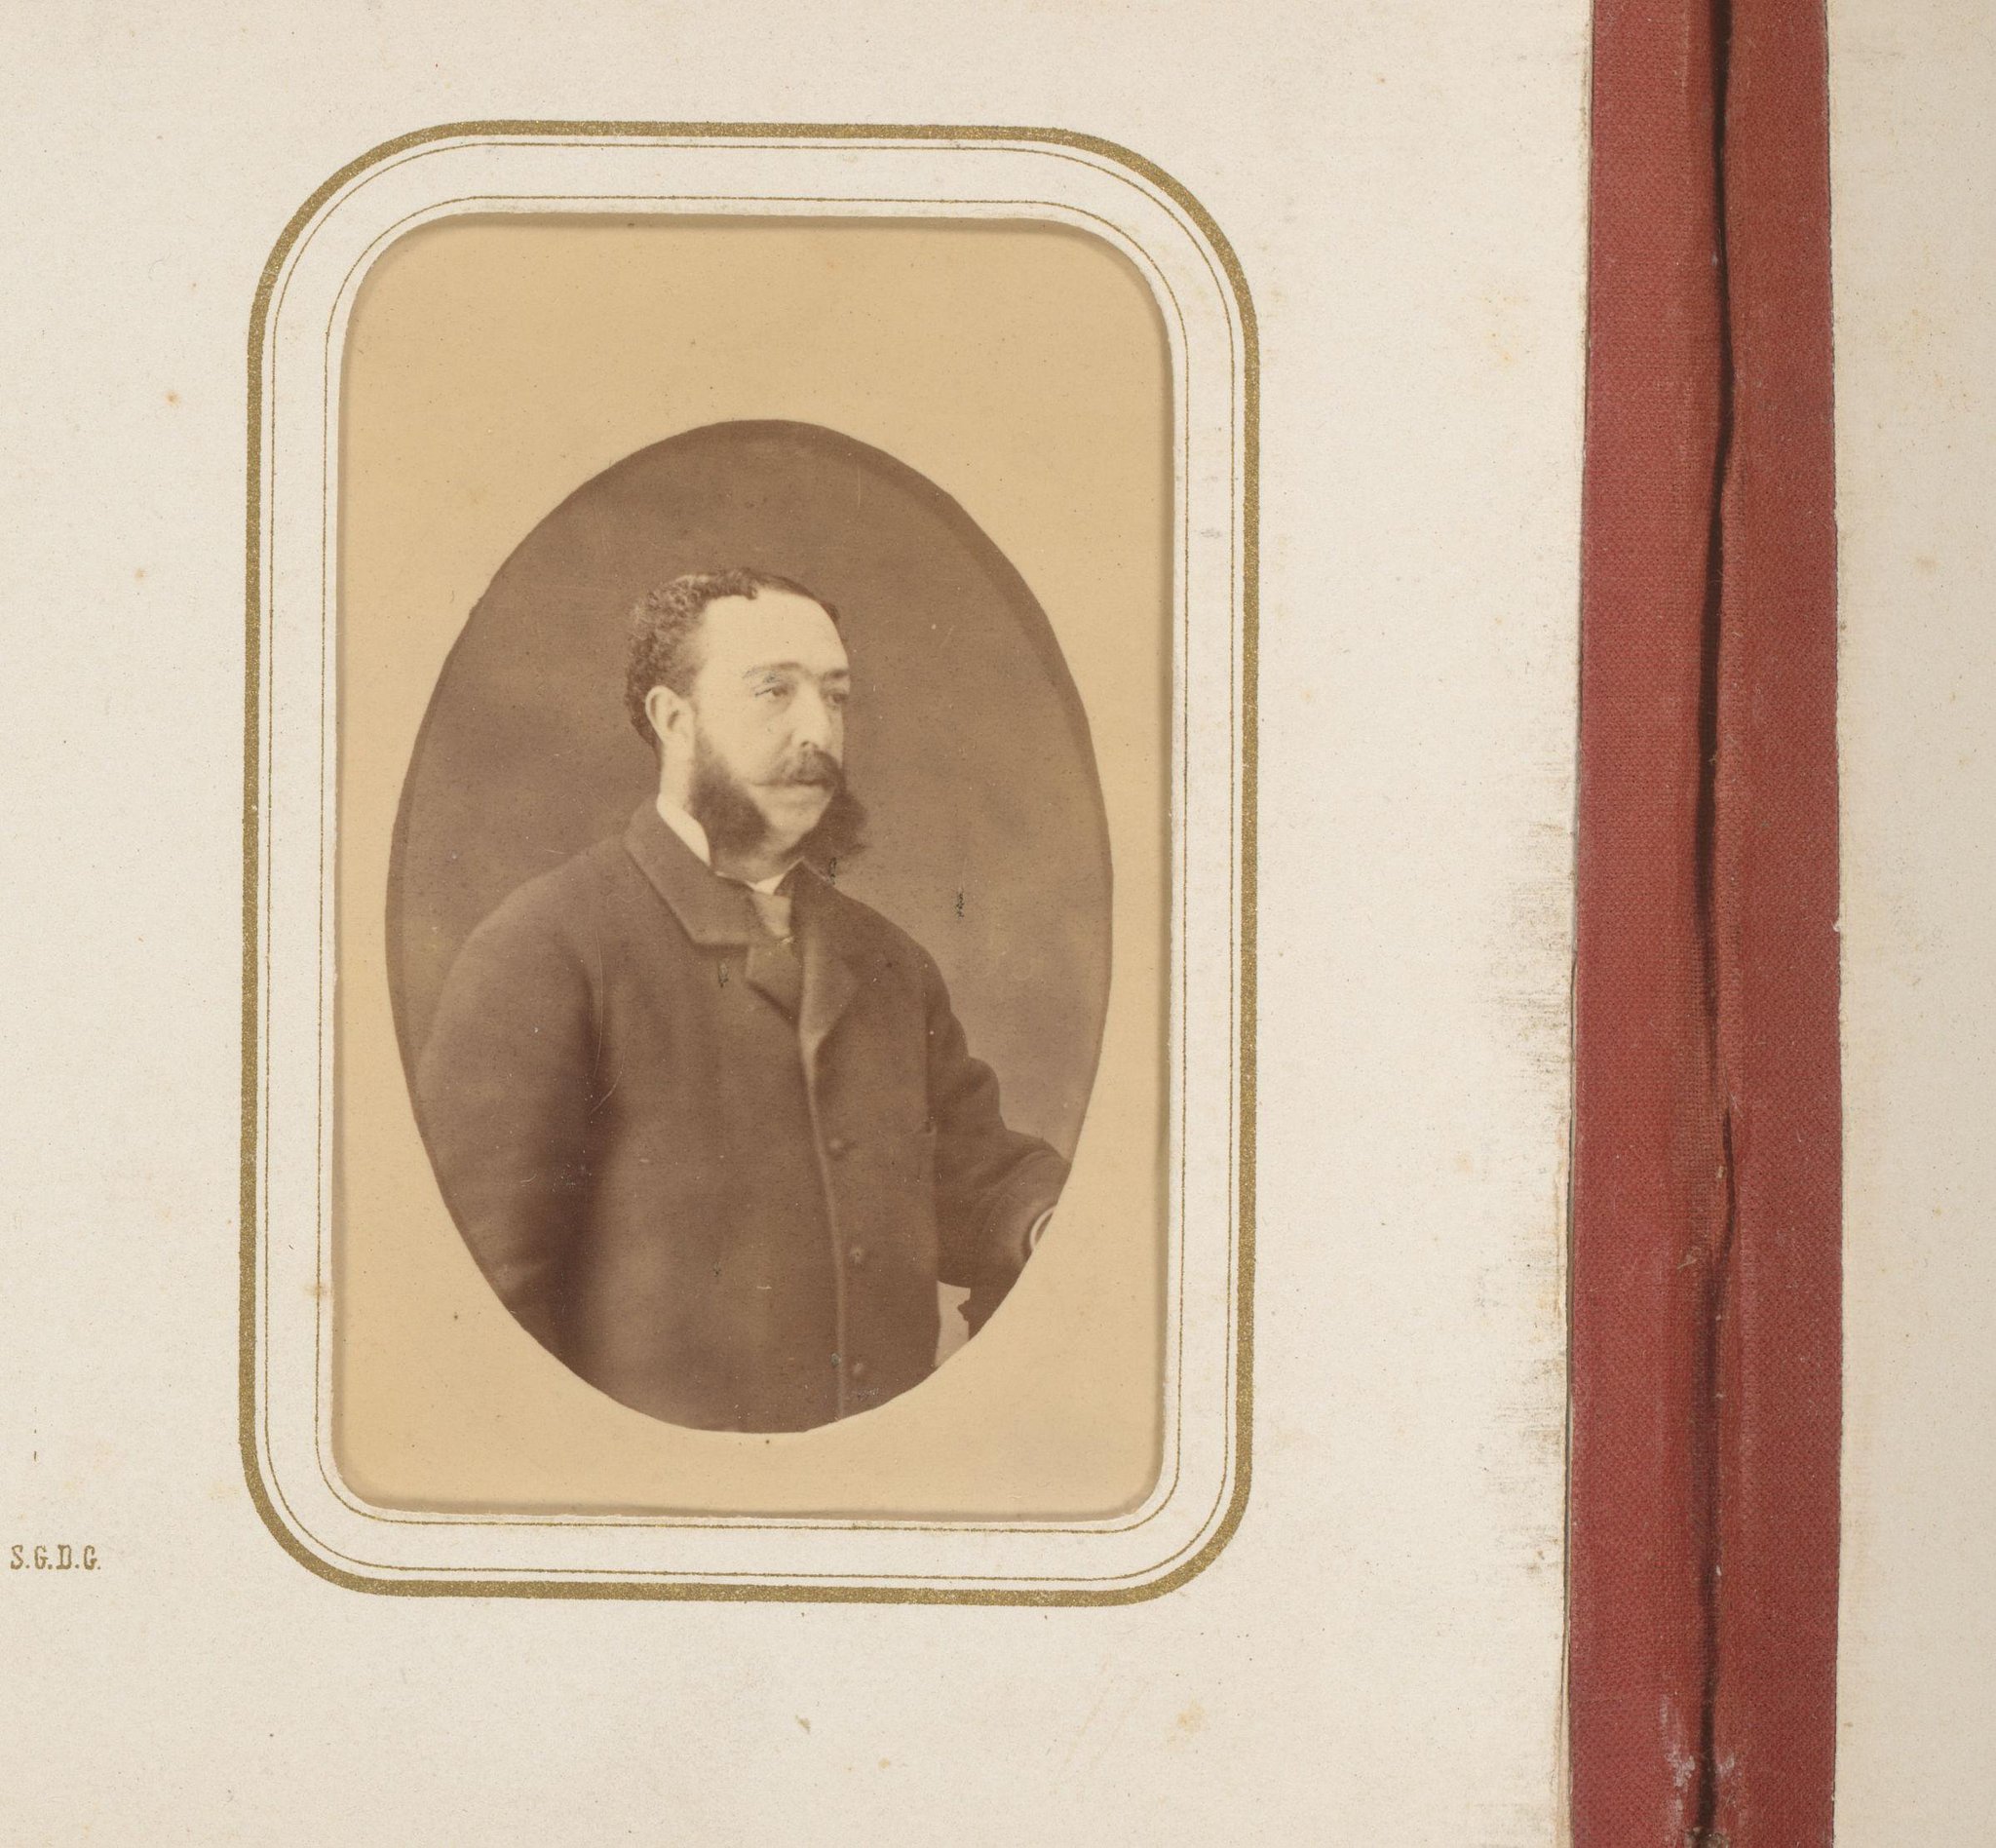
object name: photograph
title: Portret van een man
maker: Anonymous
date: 1860-1900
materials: cardboard, celluloid, photographic support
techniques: albumen print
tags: sideburns, adult man, historical persons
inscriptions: annotation: ‘Martinez’